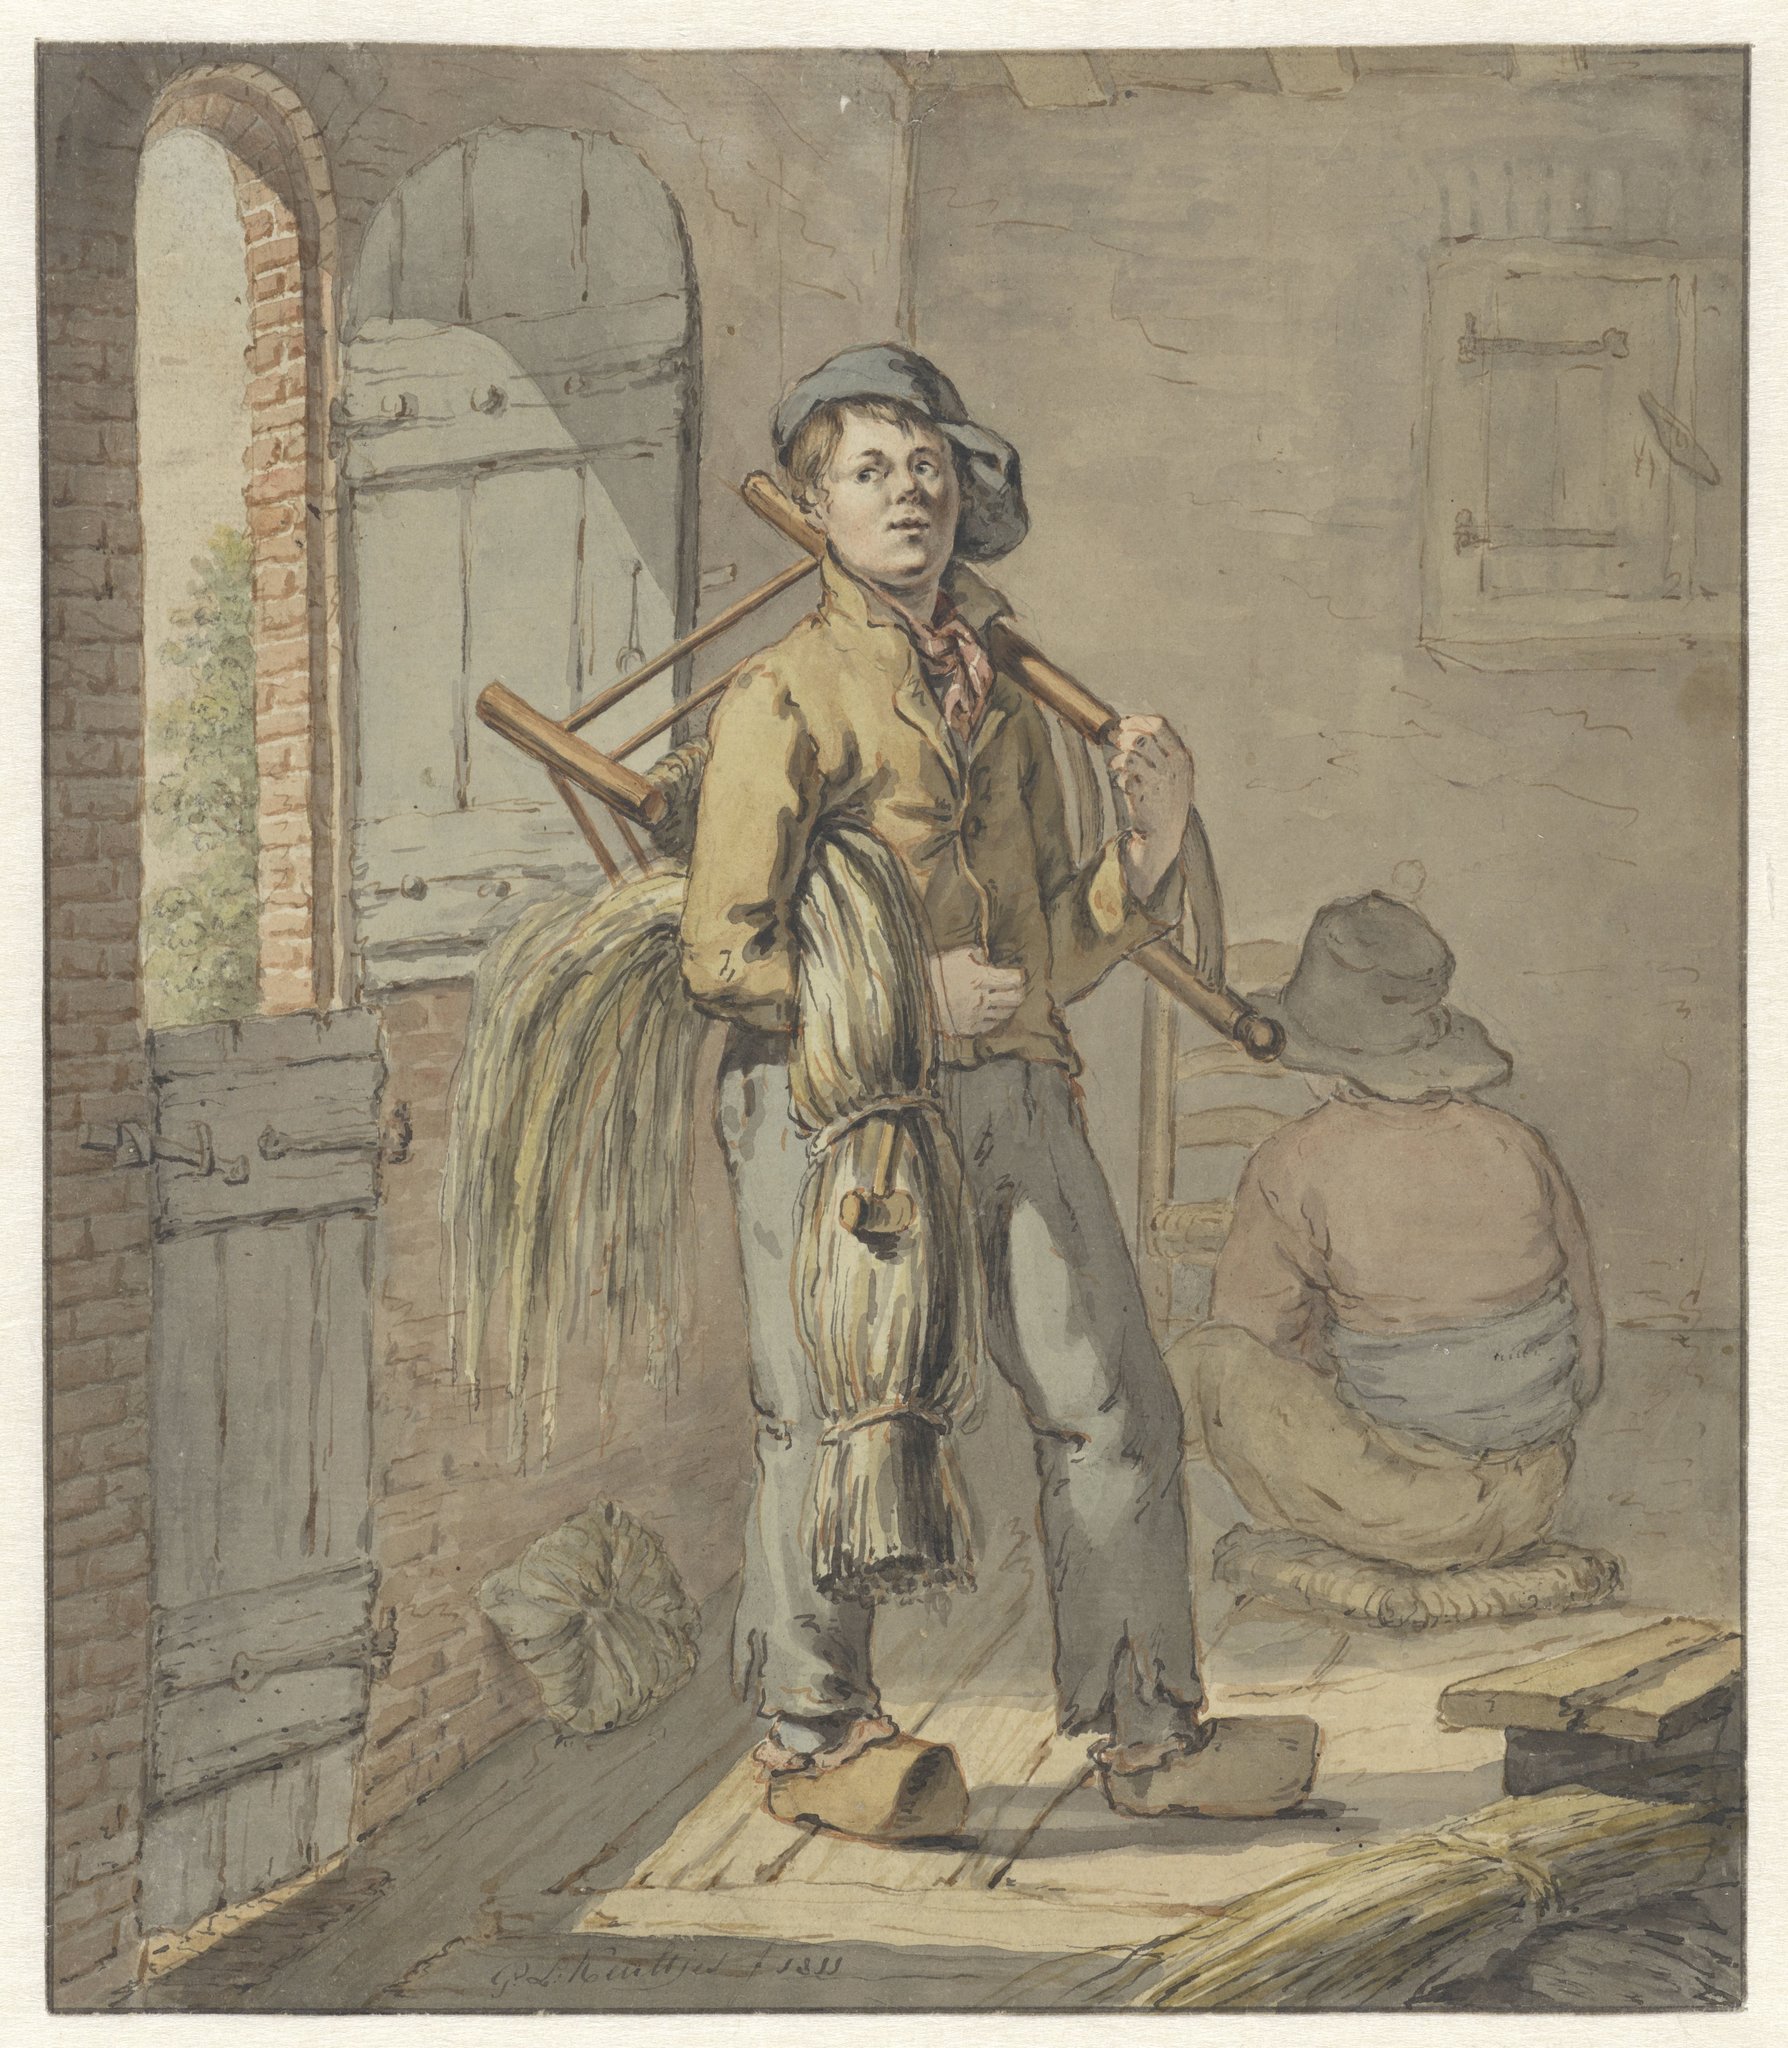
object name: watercolor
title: Stoelenmatters in een schuur aan het werk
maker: gerardus laurentius keultjes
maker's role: draughtsman, painter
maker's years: 1786-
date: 1811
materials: ink, paper, pencil, watercolor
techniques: brush, pen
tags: barn, handicrafts ~ maintenance and repair, interior of the house, chair